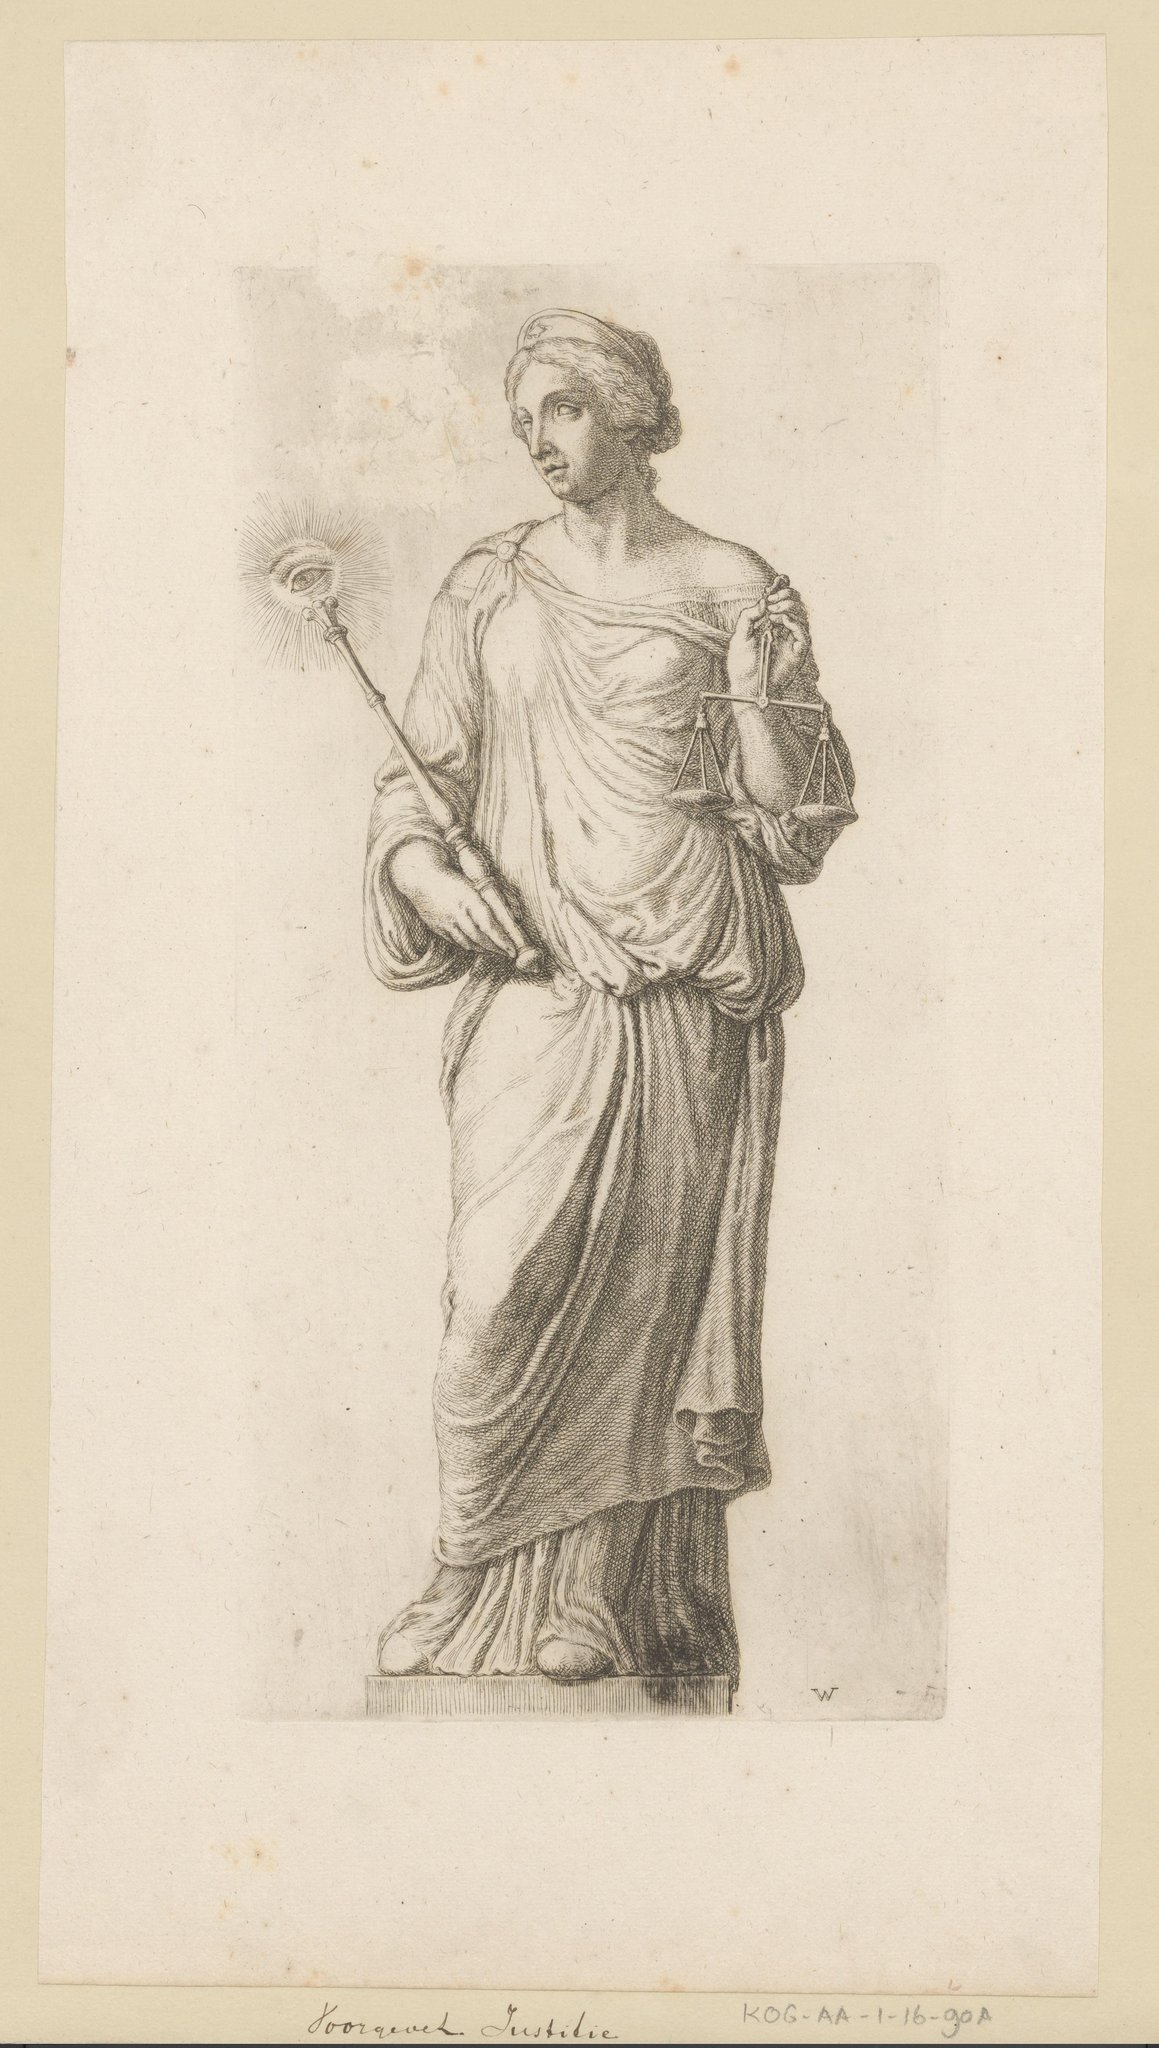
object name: print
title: Beeld van Justitia (Gerechtigheid) op de voorgevel van het Stadhuis op de Dam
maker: hubert quellinus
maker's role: print maker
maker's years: 1619-1687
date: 1663-1668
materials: paper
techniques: engraving, etching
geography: amsterdam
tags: justice, 'justitia'; 'giustitia divina' (ripa) ~ one of the four cardinal virtues, justitia (justice) as roman personification, townhall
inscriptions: collector's mark: ‘16’ Lugt 1641b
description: Prent gebruikt in: Secunca pars Praecipuarum effigierum ac ornamentorum amplissime Curiae Amstelrodamensis maiori ex parte in cadido marmore effectorum per Artum Quellinium eiusdem Civitatis Statuarium / Het tweede deel Van de voornaemste Statuen ende Cieraten van 't konst-rijcke Stadt-huys van Amstelredam 'tmeeste in Marmer gemaeckt door Artus Quellinus Beelthouwer der voorseyde Stadt. Amsterdam: Artus Quellinus (I), 1663. En in: Secunca pars Praecipuarum effigierum ac ornamentorum amplissime Curiae Amstelrodamensis maiori ex parte in cadido marmore effectorum per Artum Quellinium eiusdem Civitatis Statuarium / Het tweede deel Van de voornaemste Statuen ende Cieraten van 't konst-rijcke Stadt-huys van Amstelredam 'tmeeste in Marmer gemaeckt door Artus Quellinus Beelthouwer der voorseyde Stadt. Amsterdam: Frederik de Wit, 1668. Latere staat van prent ook gebruikt in: Architecture peinture et sculpture de la Maison de Ville d'Amsterdam, representee en CIX. figures en taille-douce (…). Amsterdam: David Mortier, 1719. En in: Architecture peinture et sculpture de la Maison de Ville d'Amsterdam, representee en CIX. figures en taille-douce (…). Amsterdam: Gerard Valck, 1719. En in: Bouw schilder en beeldhouwkonst, van het Stadhuis te Amsteldam, vertoont in CIX figuuren (…). Amsterdam: Covens & Mortier & Covens Jr., s.a. (1774-1783).